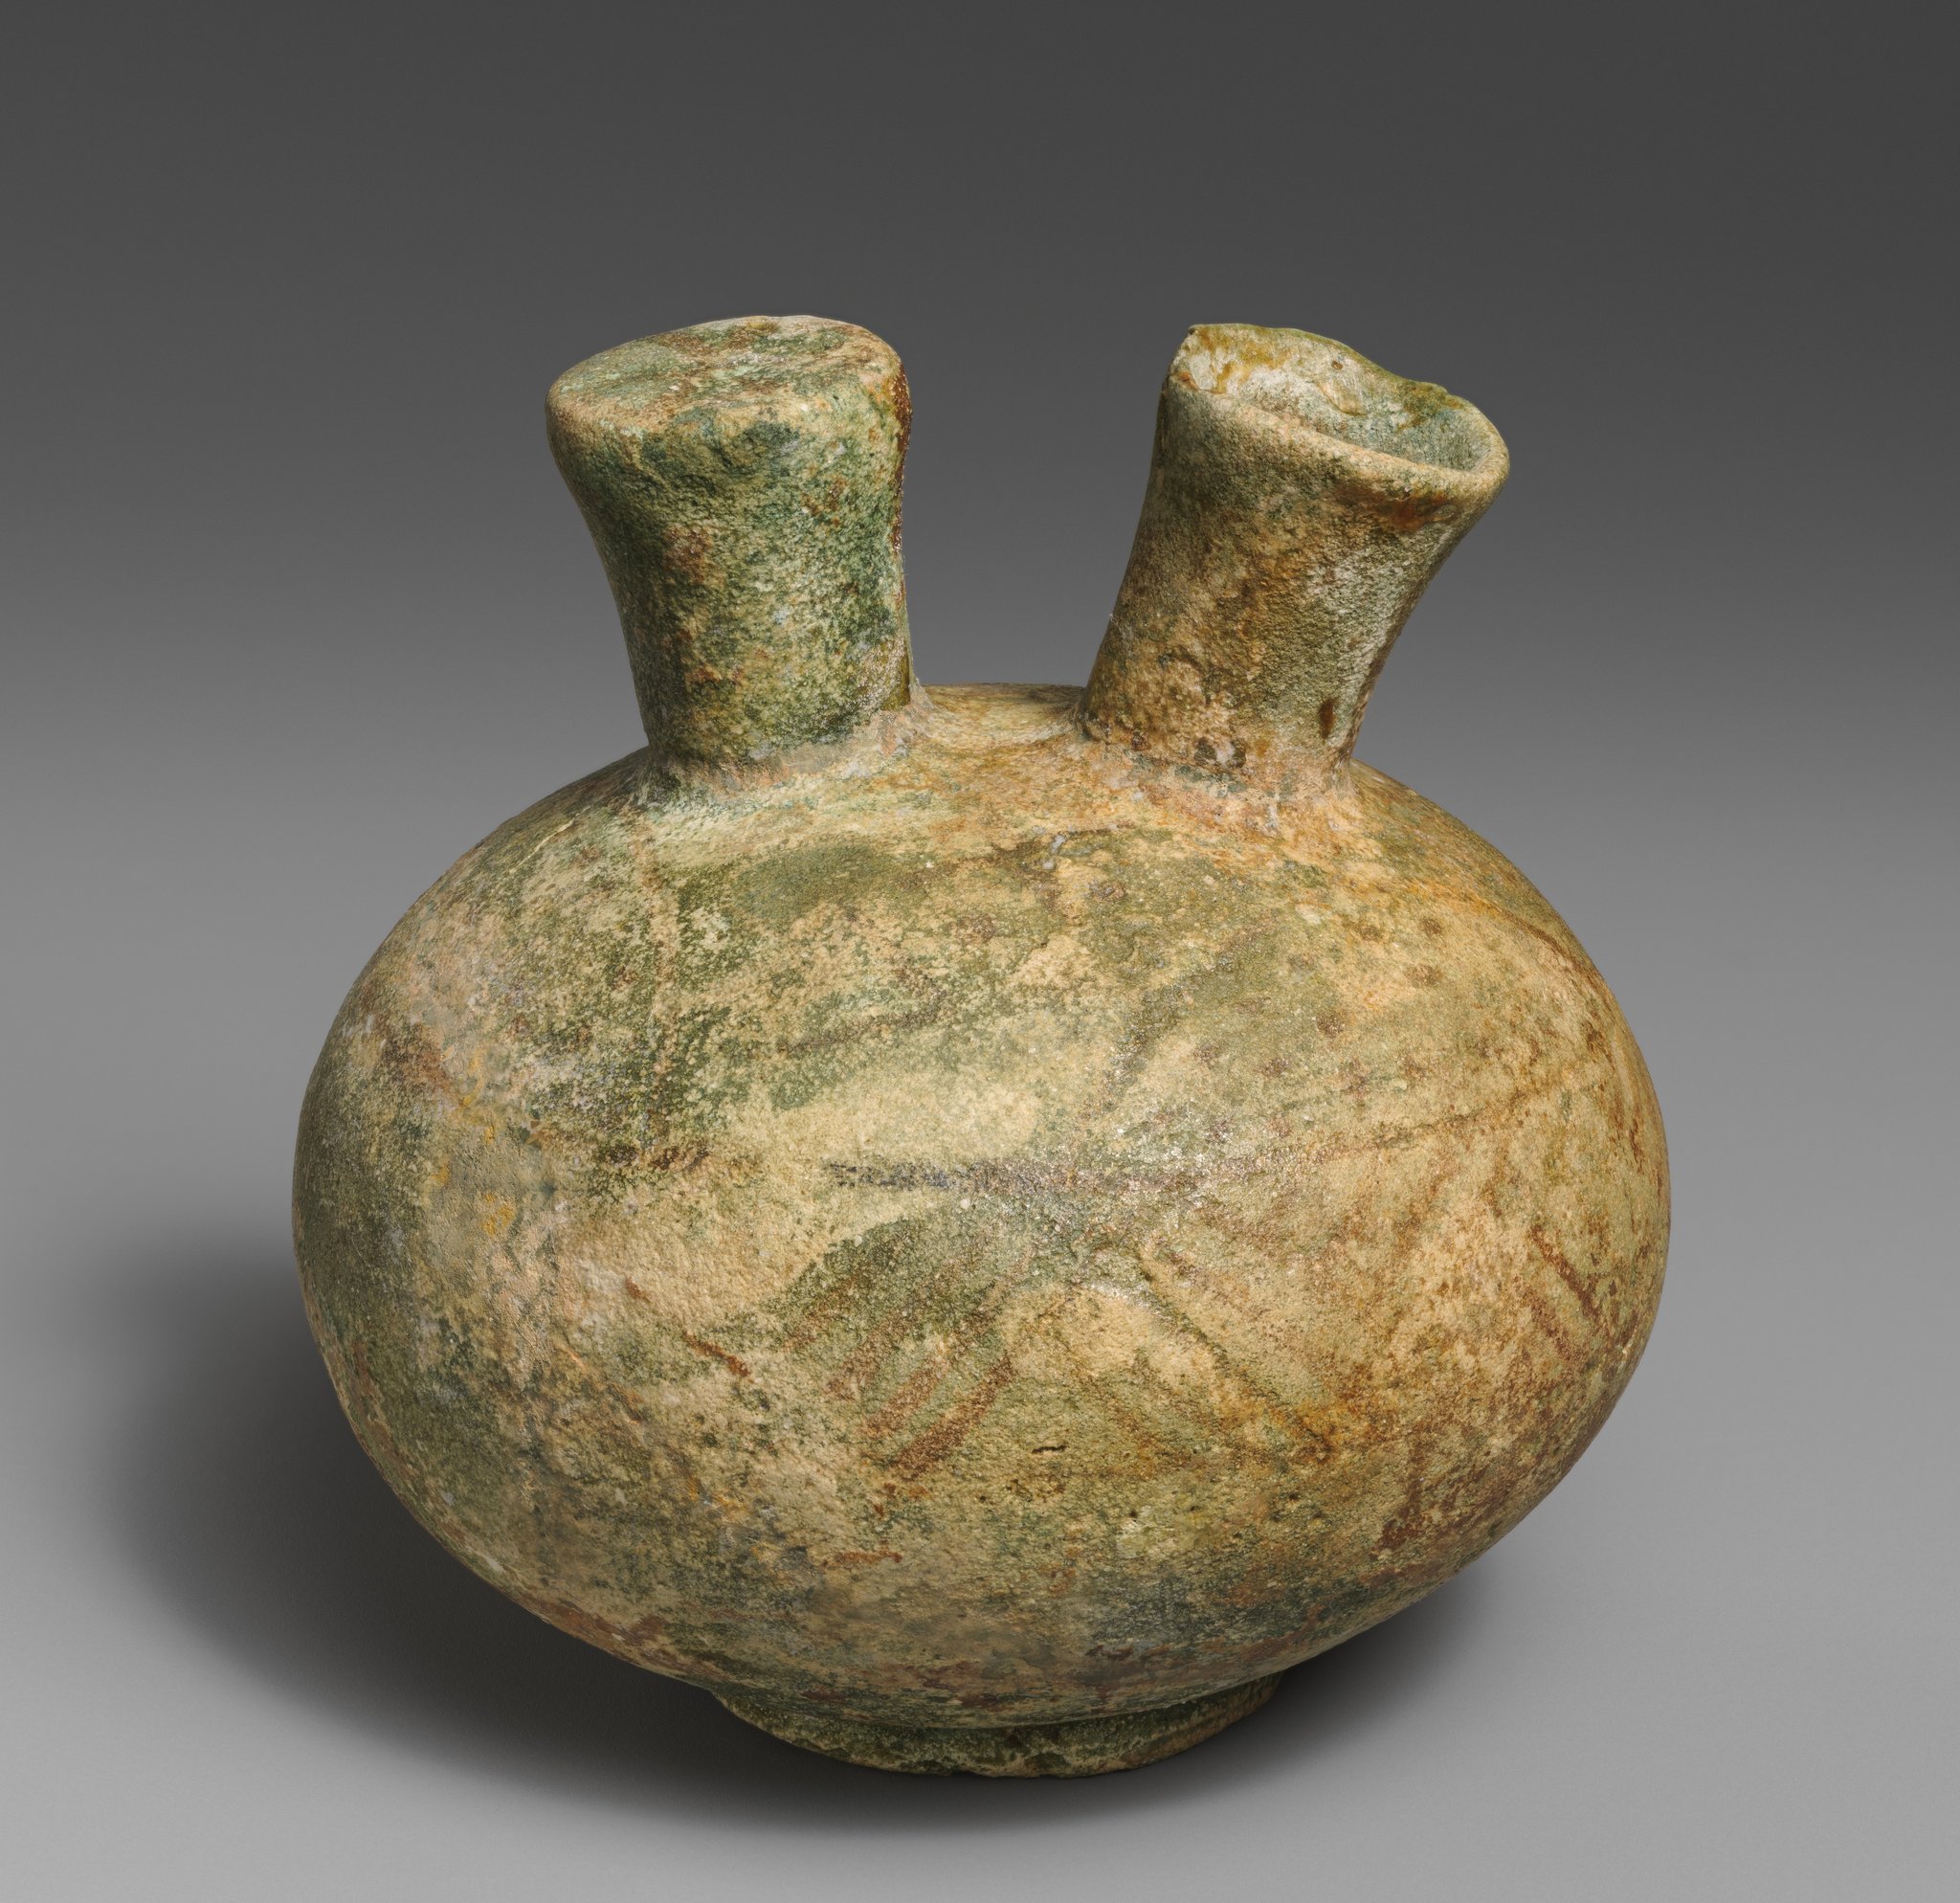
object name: flask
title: Faience stirrup jar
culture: cypriot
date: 1300-1101 BCE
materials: faience